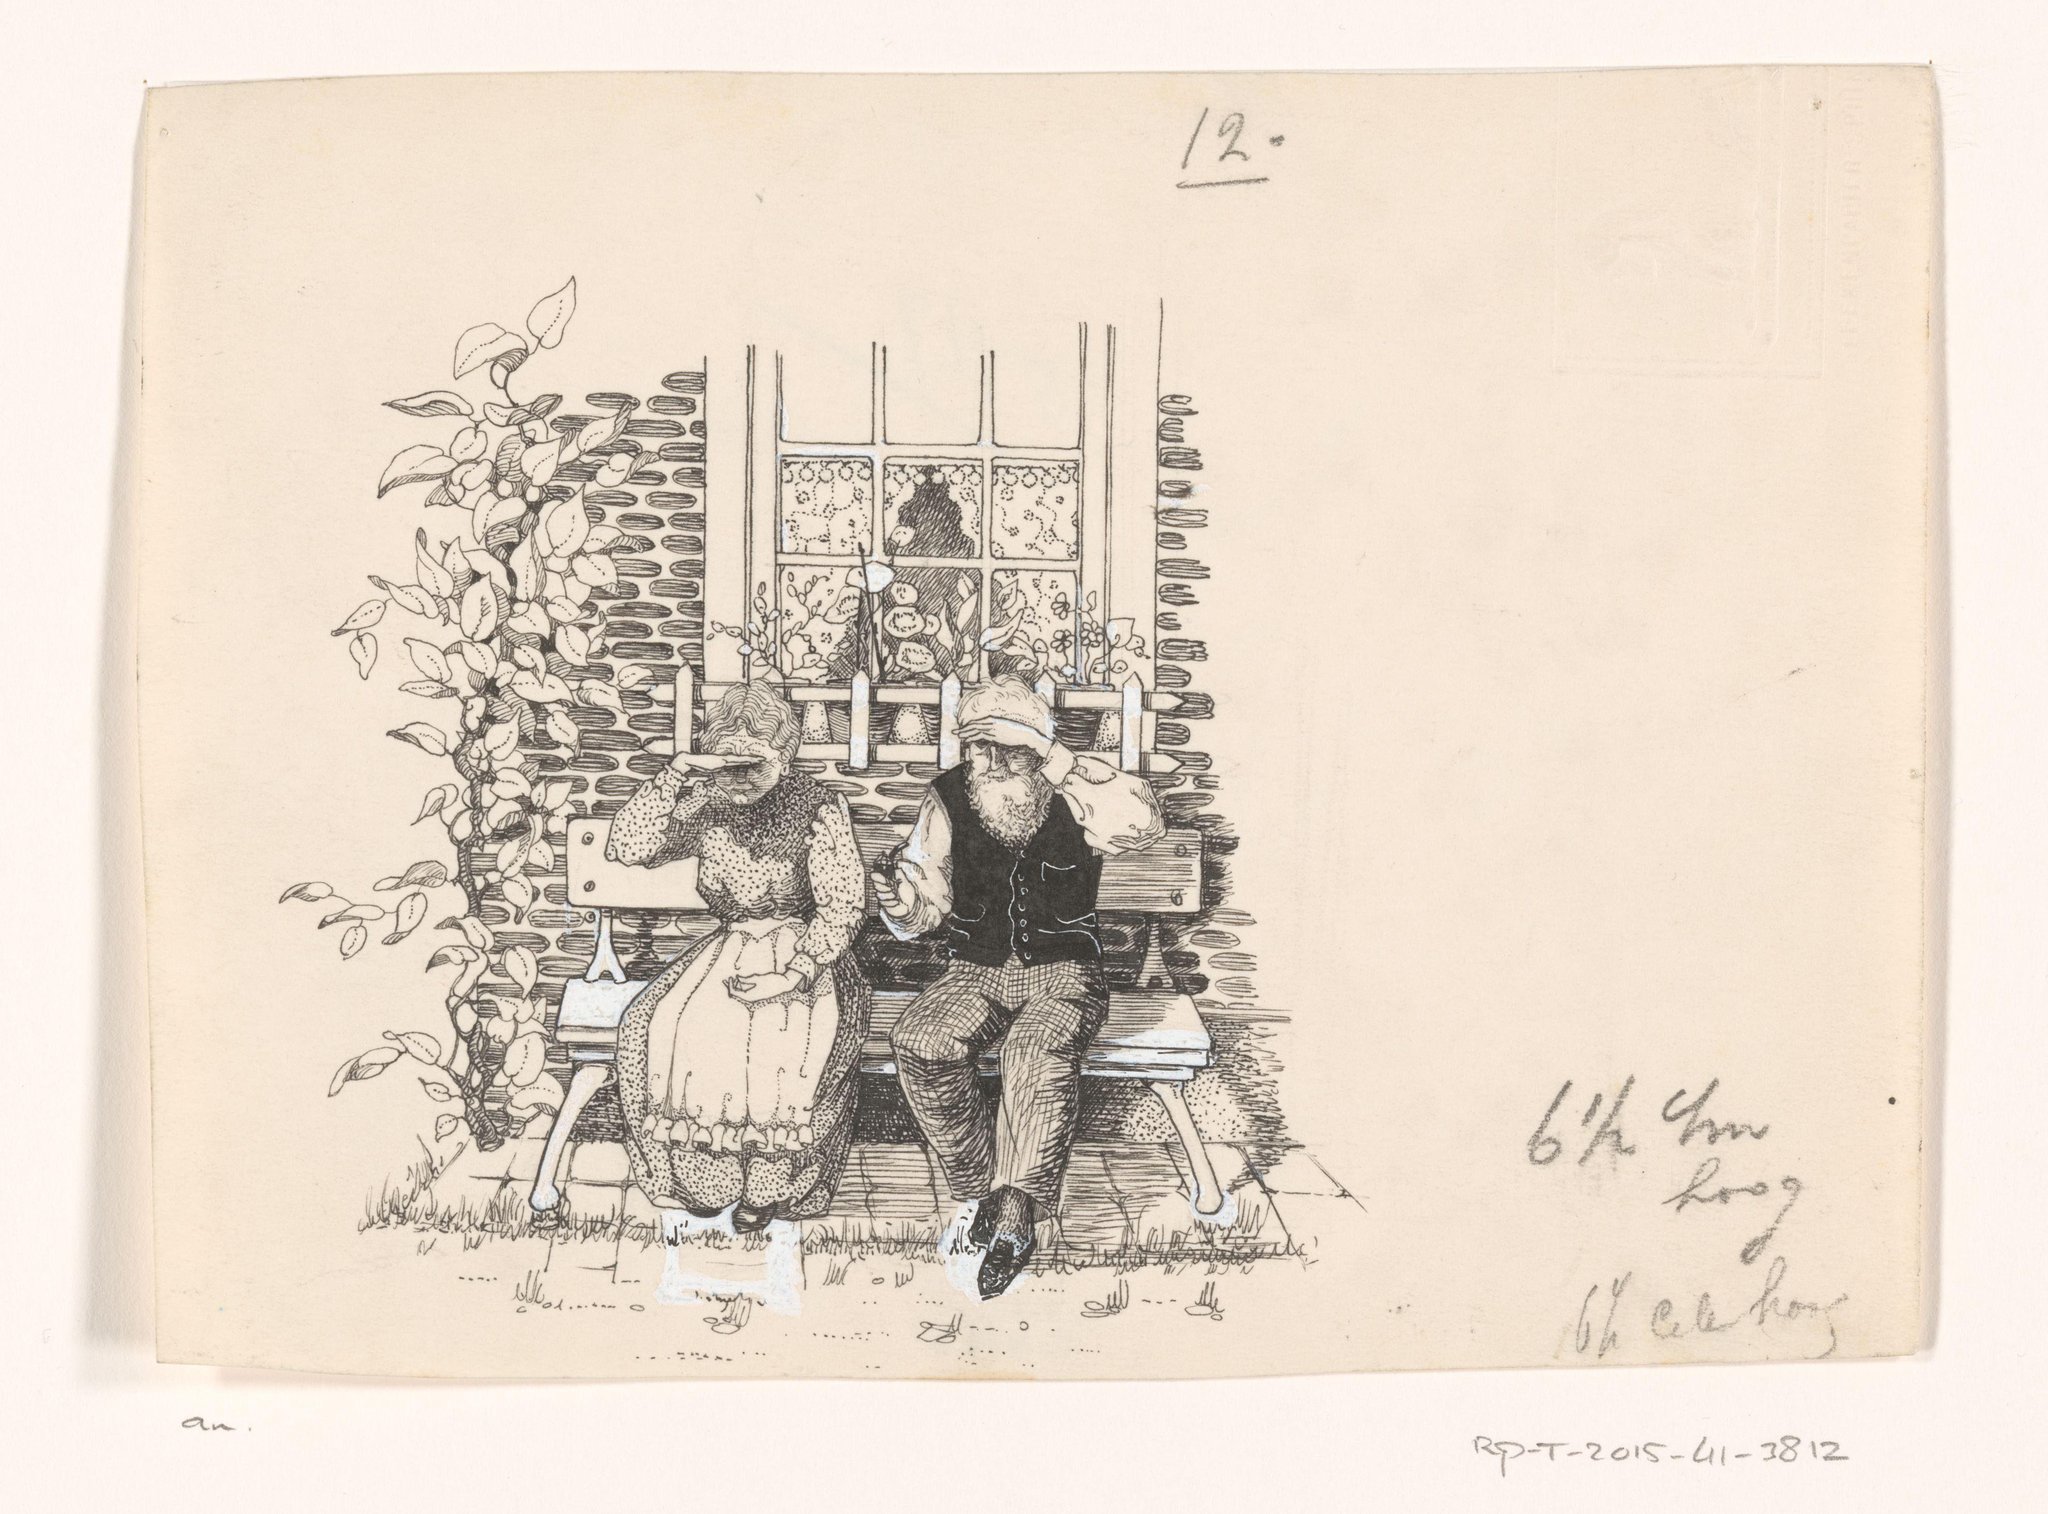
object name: drawing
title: Oude man en vrouw op een bank voor een huis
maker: Anonymous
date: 1890-1930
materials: paint, ink, paper, pencil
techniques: brush, pen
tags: bench, hand towards the forehead, old man, old woman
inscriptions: collector's mark: Lugt 2228a, number: ‘12.’, :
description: De man en vrouw houden beiden hun hand boven hun ogen om beter te kunnen kijken. De man heeft een pijp in zijn hand.